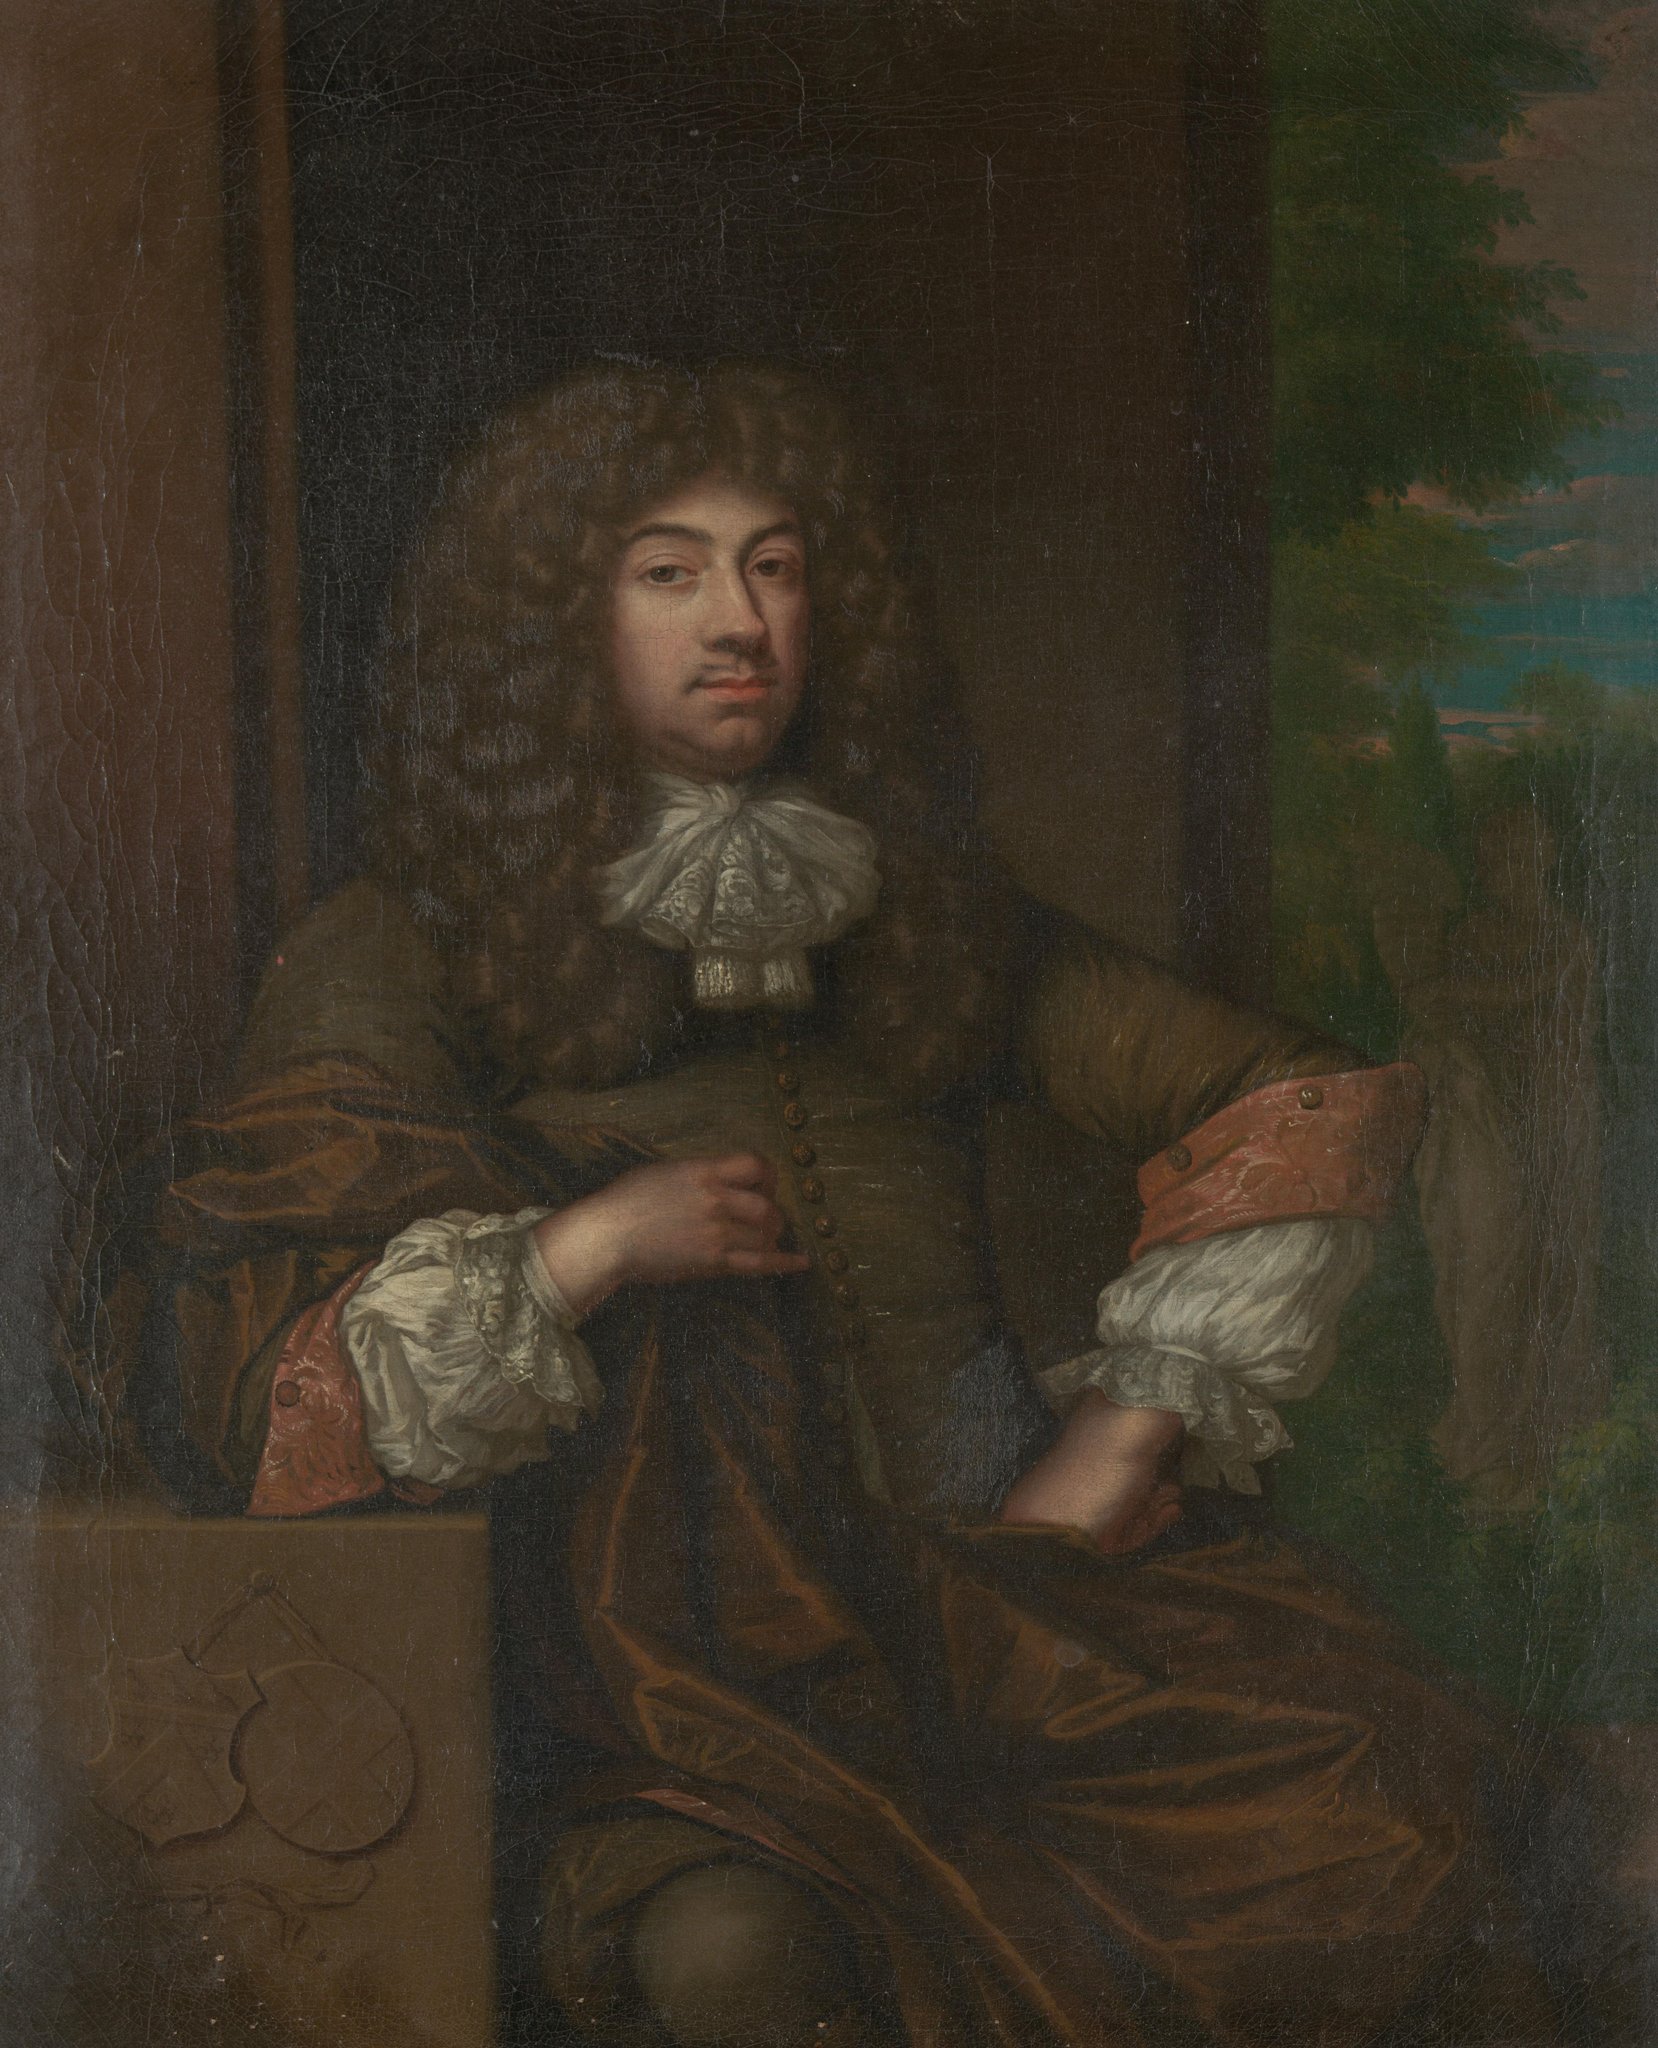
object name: painting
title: Portrait of Jan Boudaen Courten (1635-1716), lord of St. Laurens, Schellach and Popkensburg, Judge and alderman of Middelburg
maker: philip van dijk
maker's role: draughtsman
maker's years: 1683-1753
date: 1690-1753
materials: canvas, oil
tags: historical persons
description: Portret van Jan Boudaen Courten, heer van St Laurens, Schellach en Popkensburg. Raad van Middelburg en bewindhebber der VOC. Kniestuk, zittend, rechts een tuin met een beeld van een vrouw met een horen des overvloeds. Kopie door Philip van Dijk naar het origineel van Caspar Netscher. Pendant van SK-A-902.